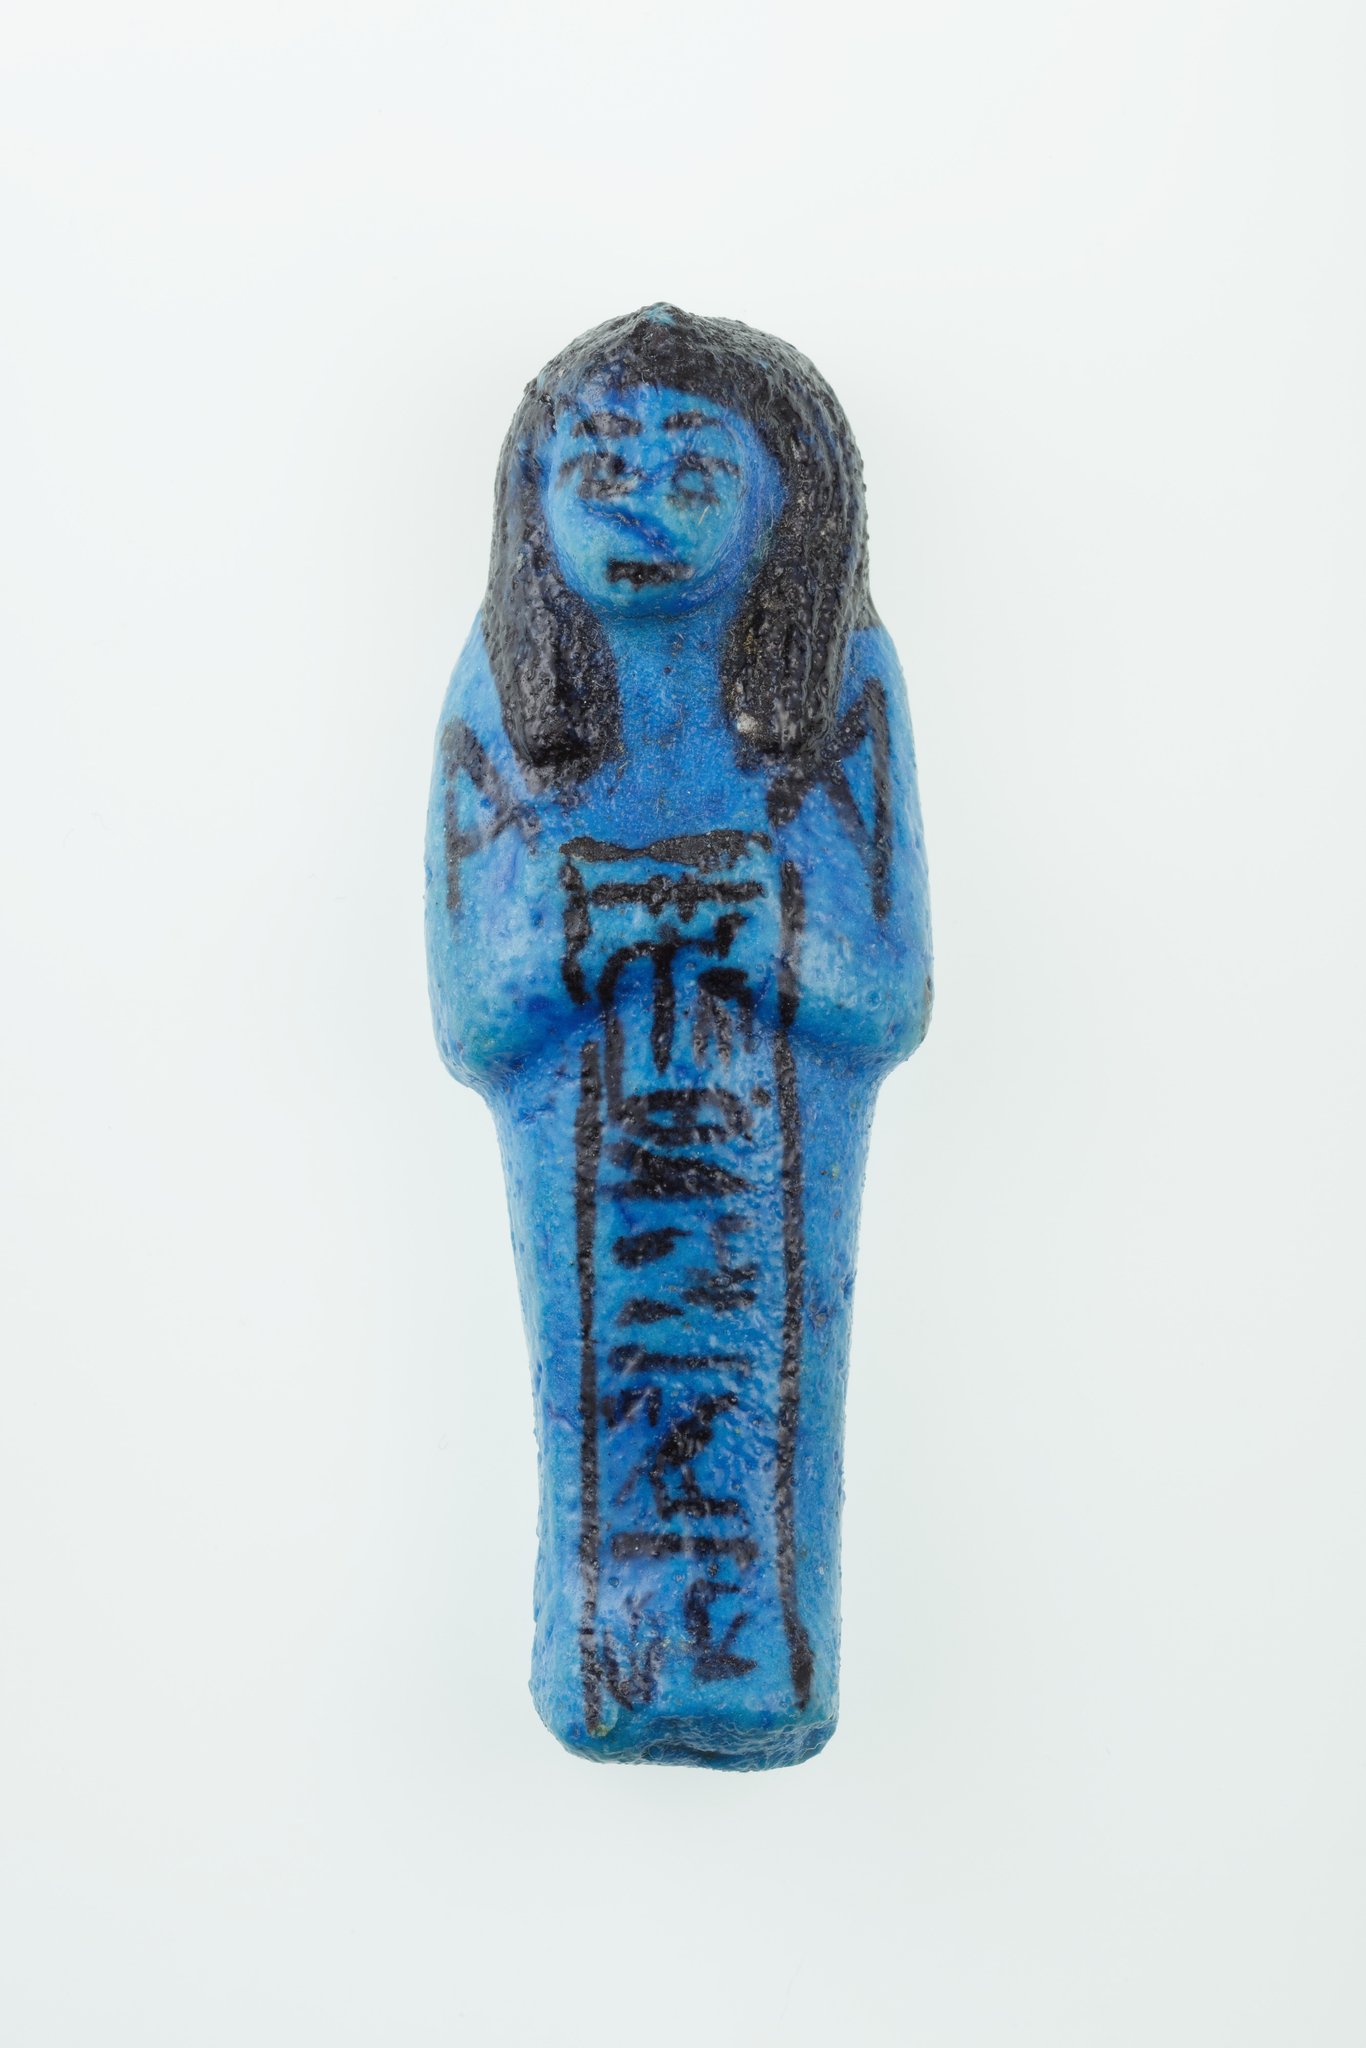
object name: shabti, worker, nauny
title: Worker Shabti of Nauny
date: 1050 BCE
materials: faience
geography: egypt